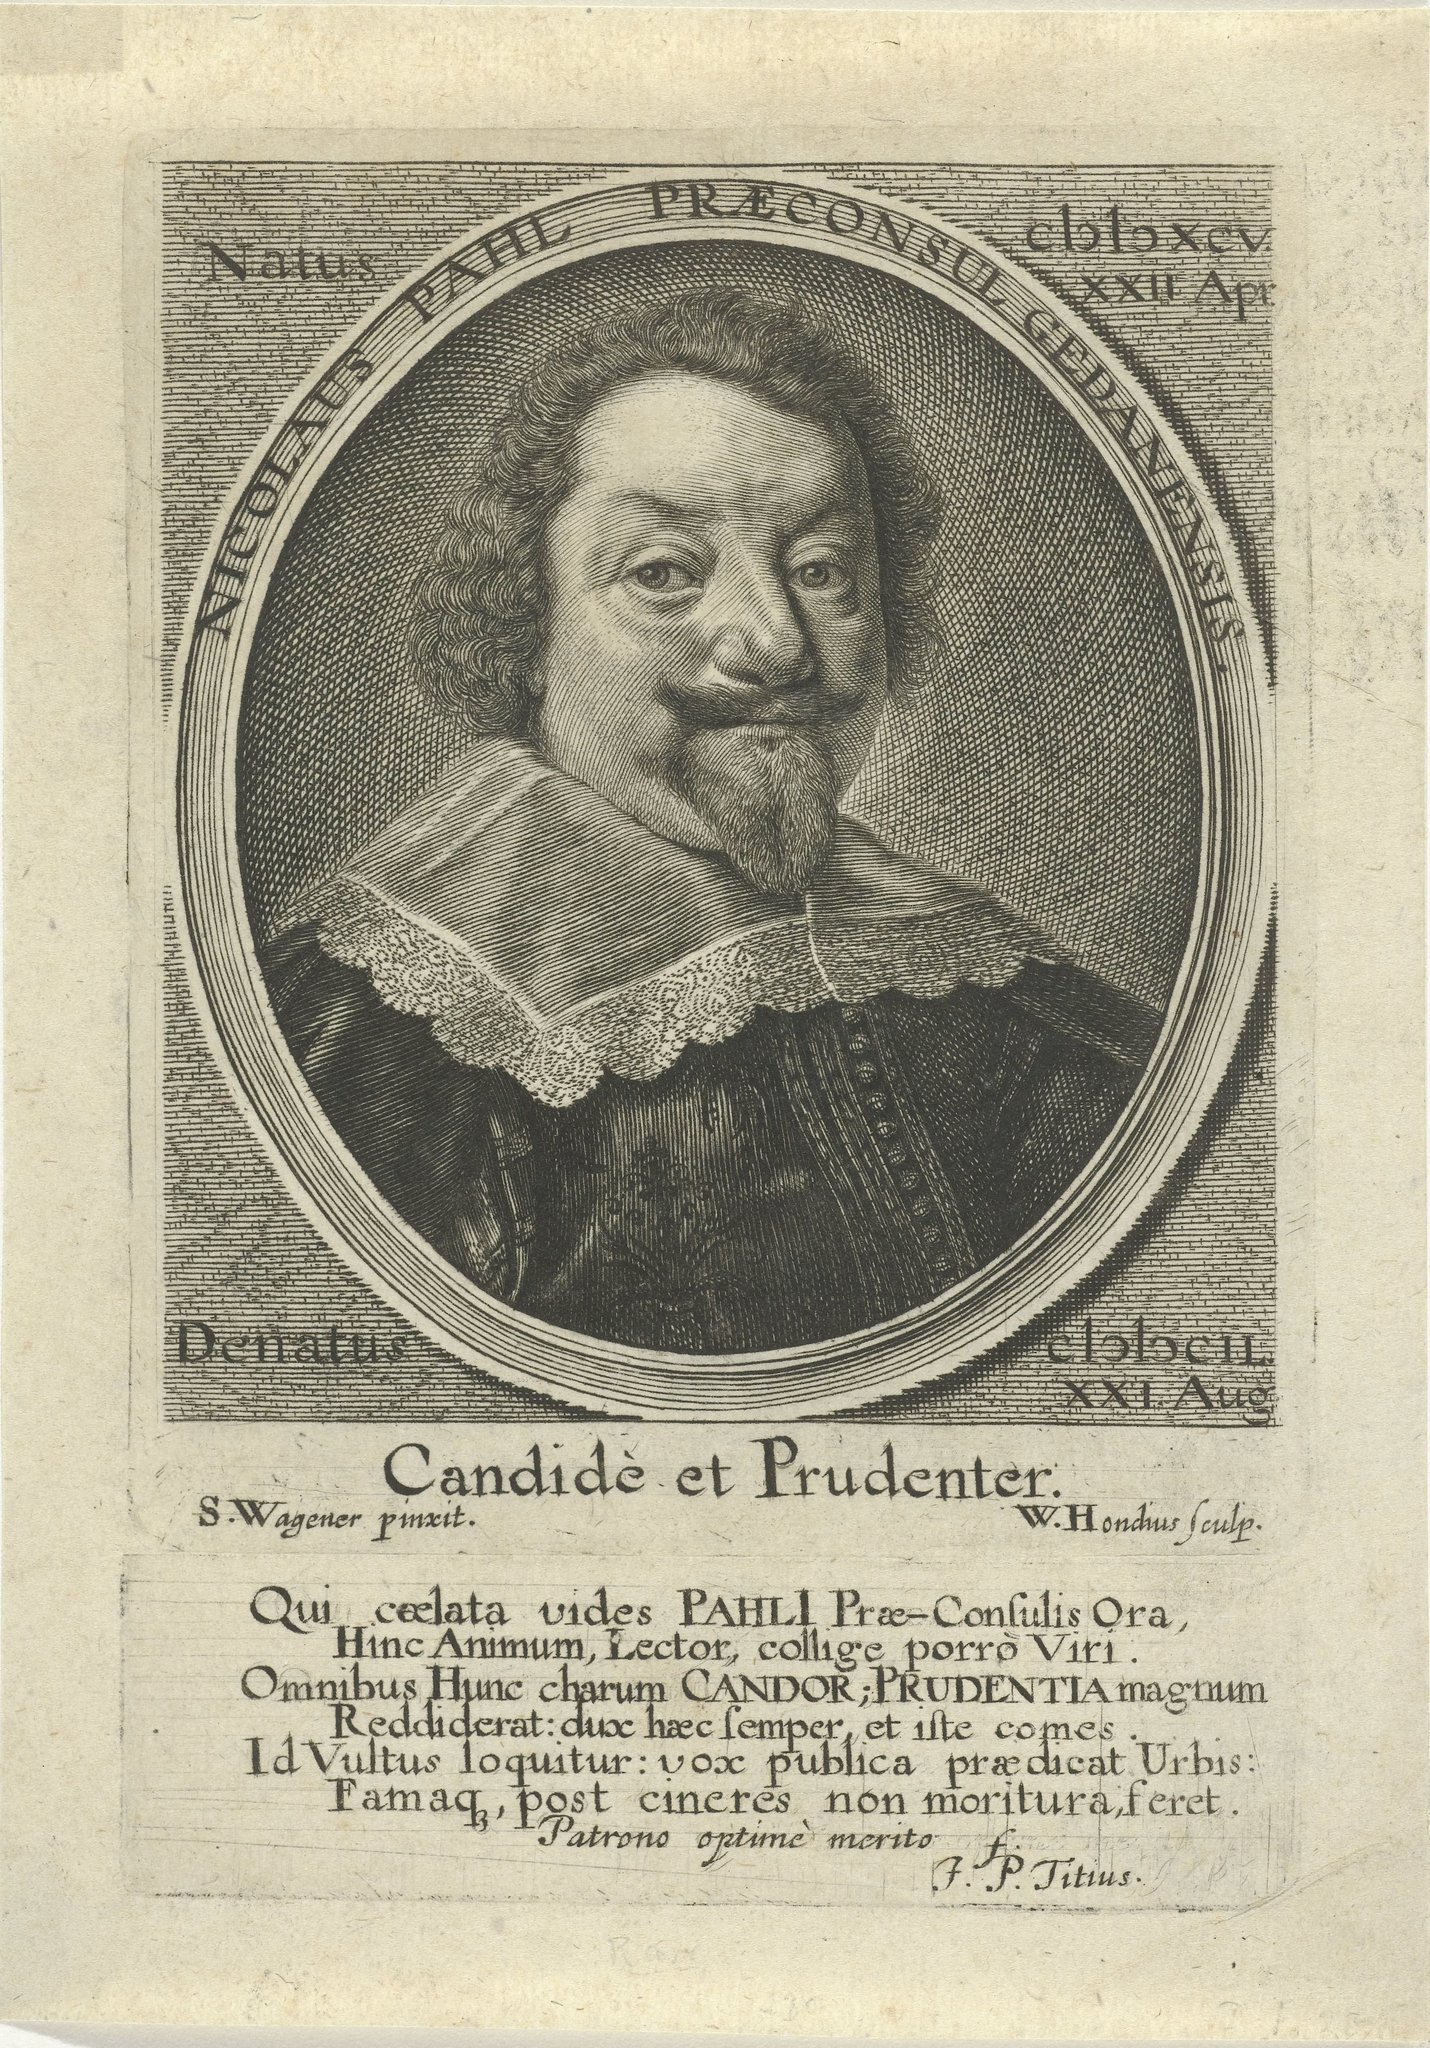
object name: print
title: Portret van Nicolas Pahl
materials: paper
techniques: engraving, etching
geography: poland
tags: nicolas pahl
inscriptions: collector's mark: Lugt 2228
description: Buste naar rechts van Nicolas Pahl in een ovale omlijsting met randschrift in het Latijn. Onder het portret een tweede druk met zesregelige tekst van de schrijver Johann Petrus Titius.